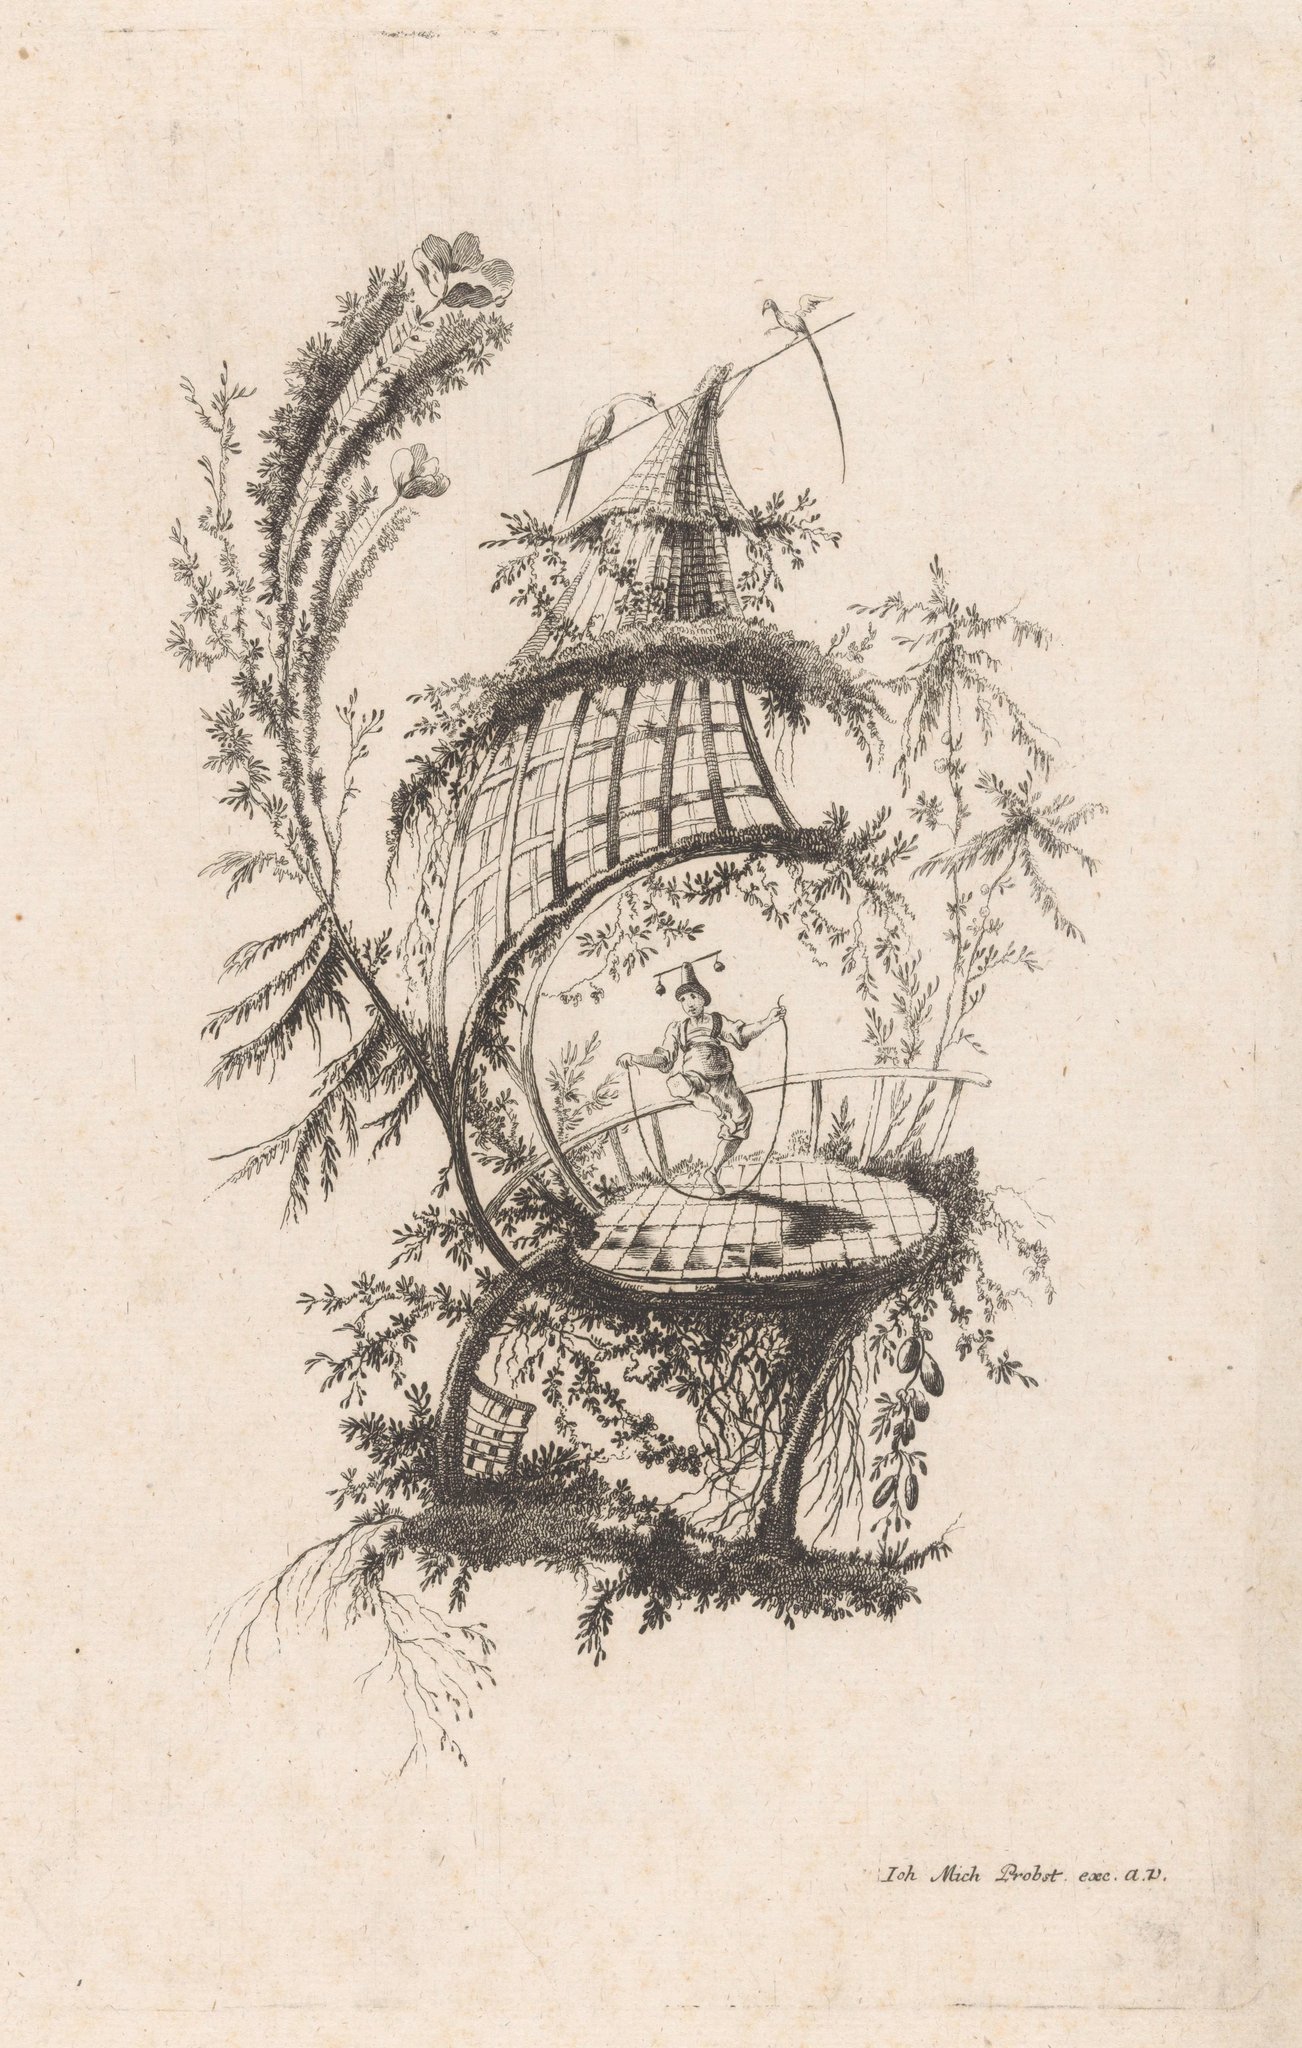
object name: ornament print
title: Cahier de six Baraques Chinoises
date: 1776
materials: paper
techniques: etching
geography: augsburg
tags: jumping up, jumping-rope games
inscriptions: collector's mark: Lugt 2760, collector's mark: Lugt 2228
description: In een landschap onder een puntig afdak springt een man met een springtouw. De man draagt bellen op zijn hoed. Op het afdak zitten twee vogels op een tak.